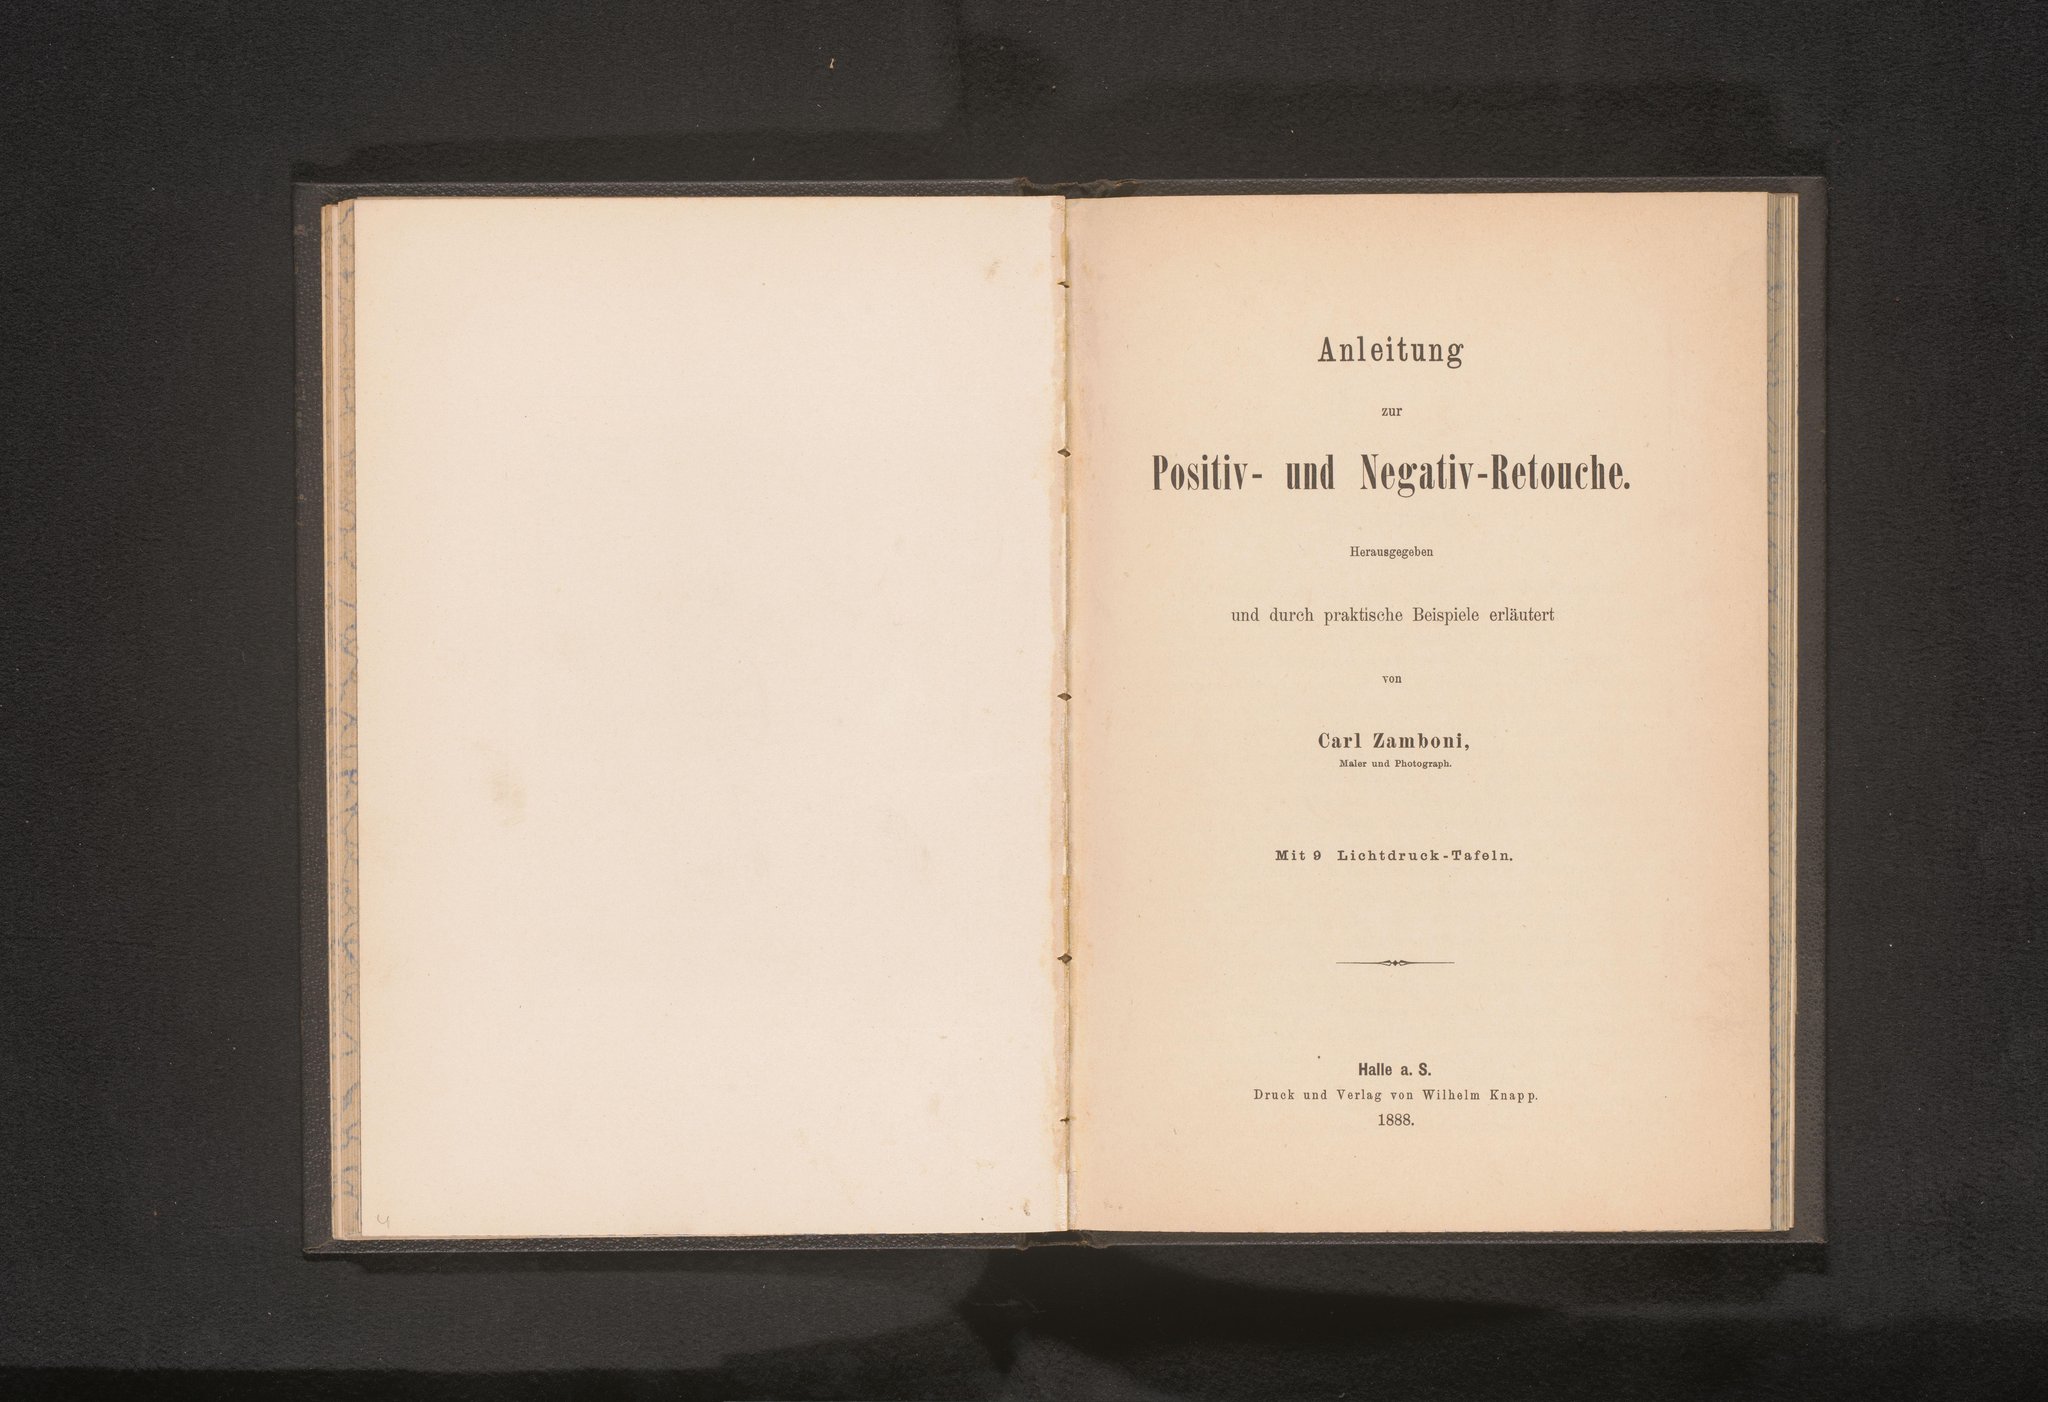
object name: book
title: Anleitung zur Positiv- und Negativ-Retouche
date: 1888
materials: cardboard, linen, paper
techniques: photograph, printing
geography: halle an der saale